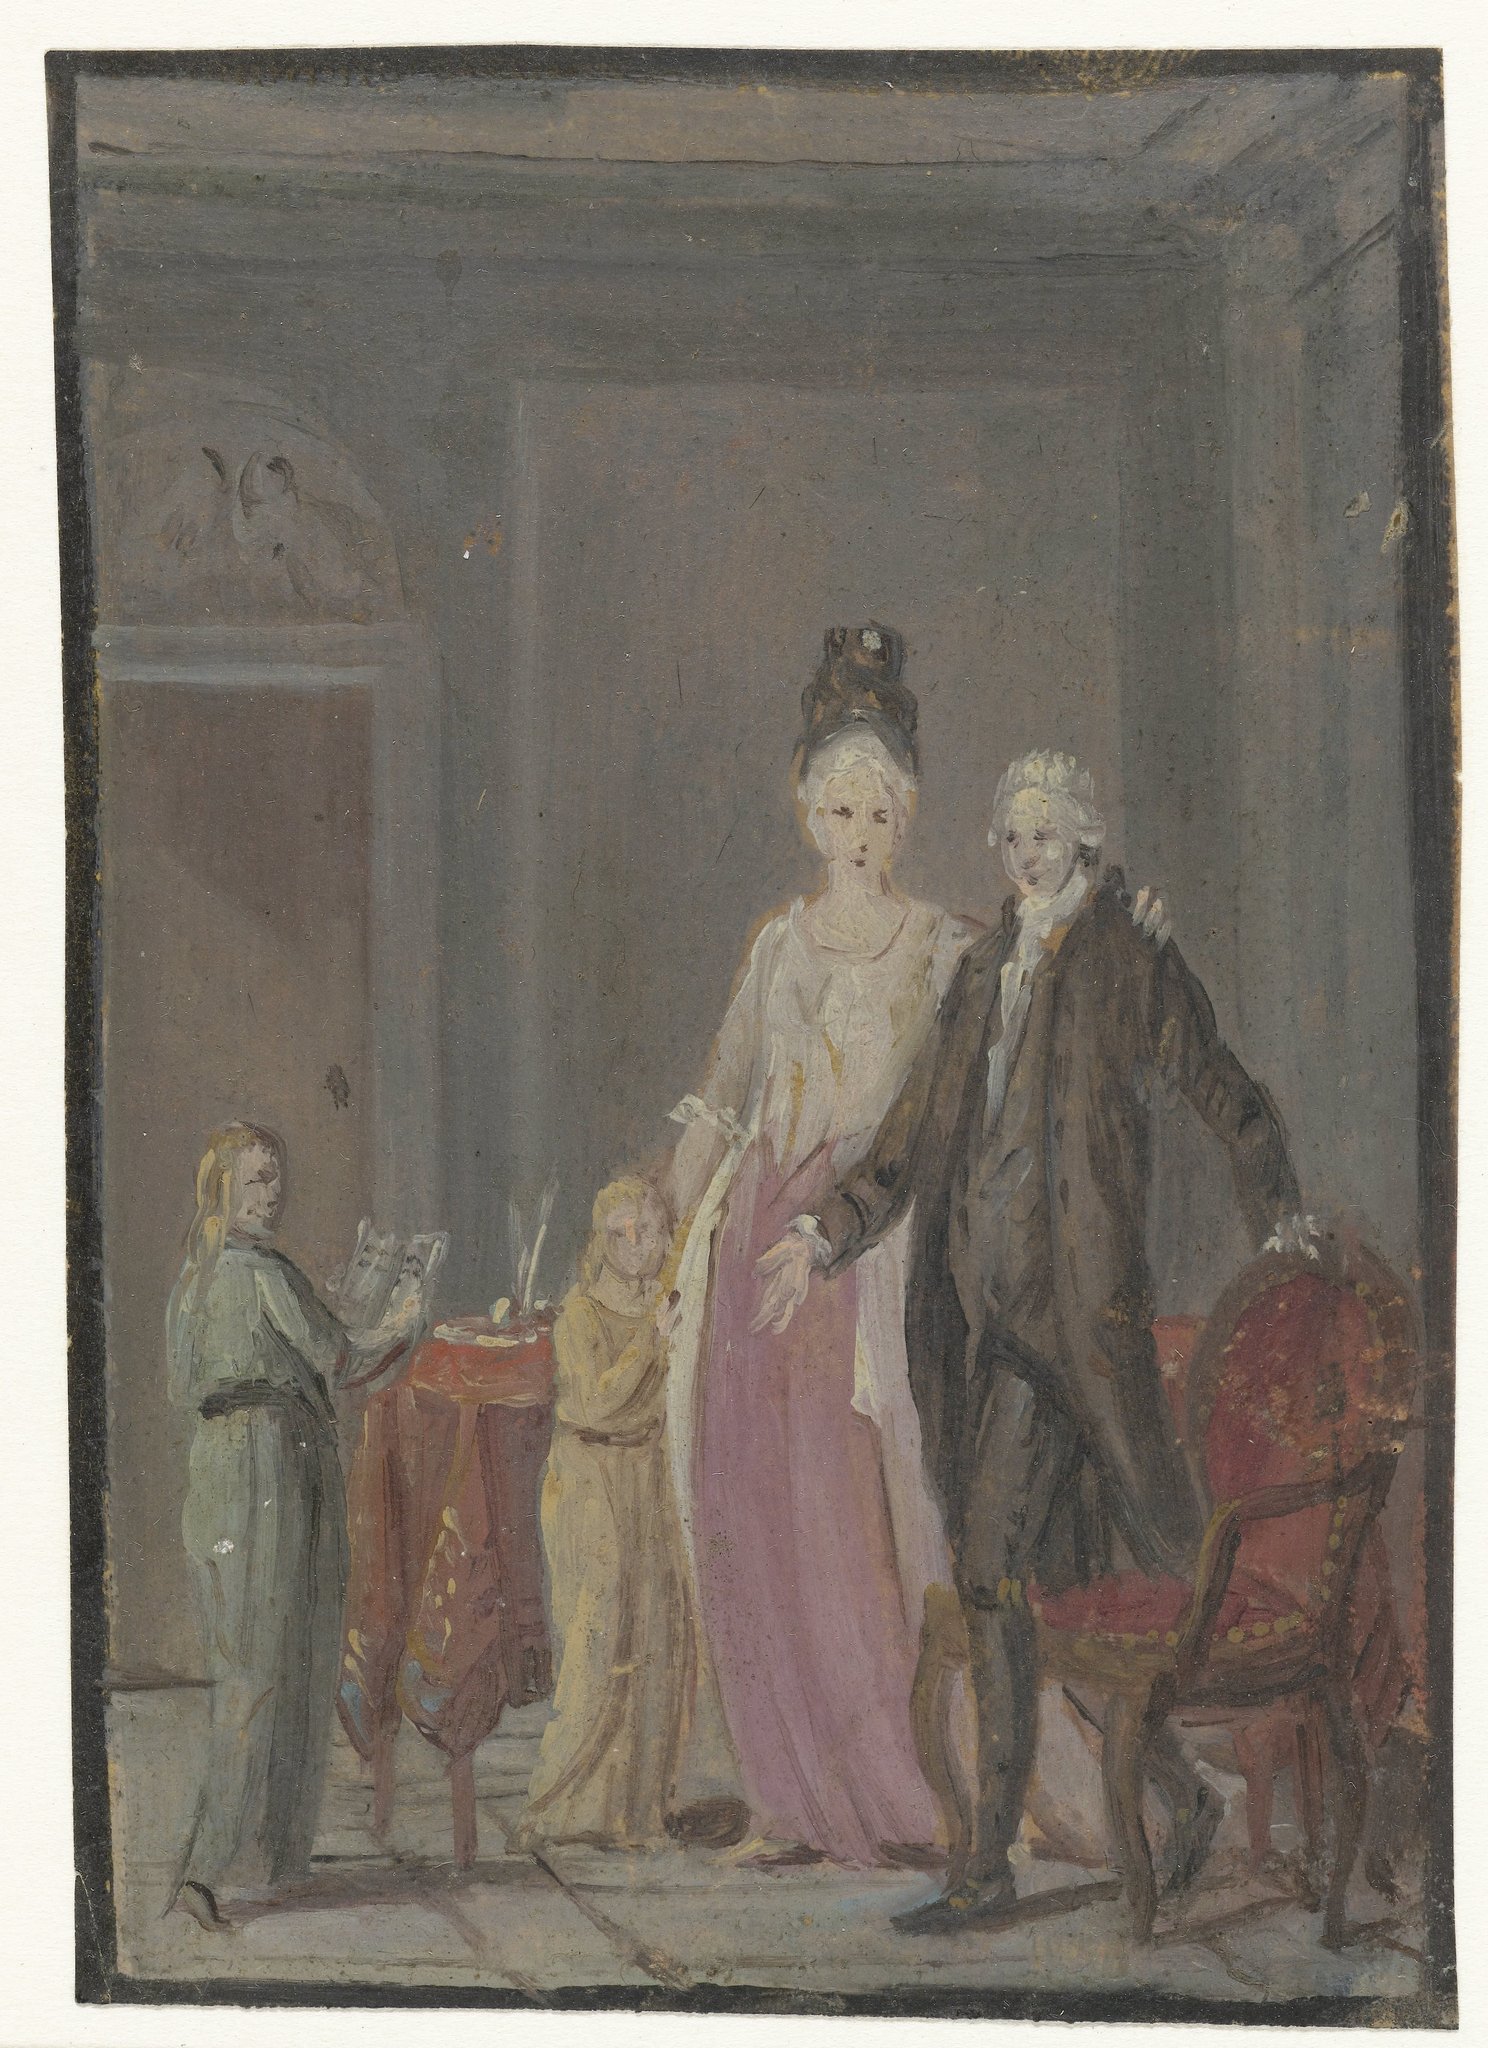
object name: drawing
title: Familiegroep in interieur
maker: Anonymous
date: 1700-1800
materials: oil, paper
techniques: brush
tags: family group, especially parents with their child(ren)